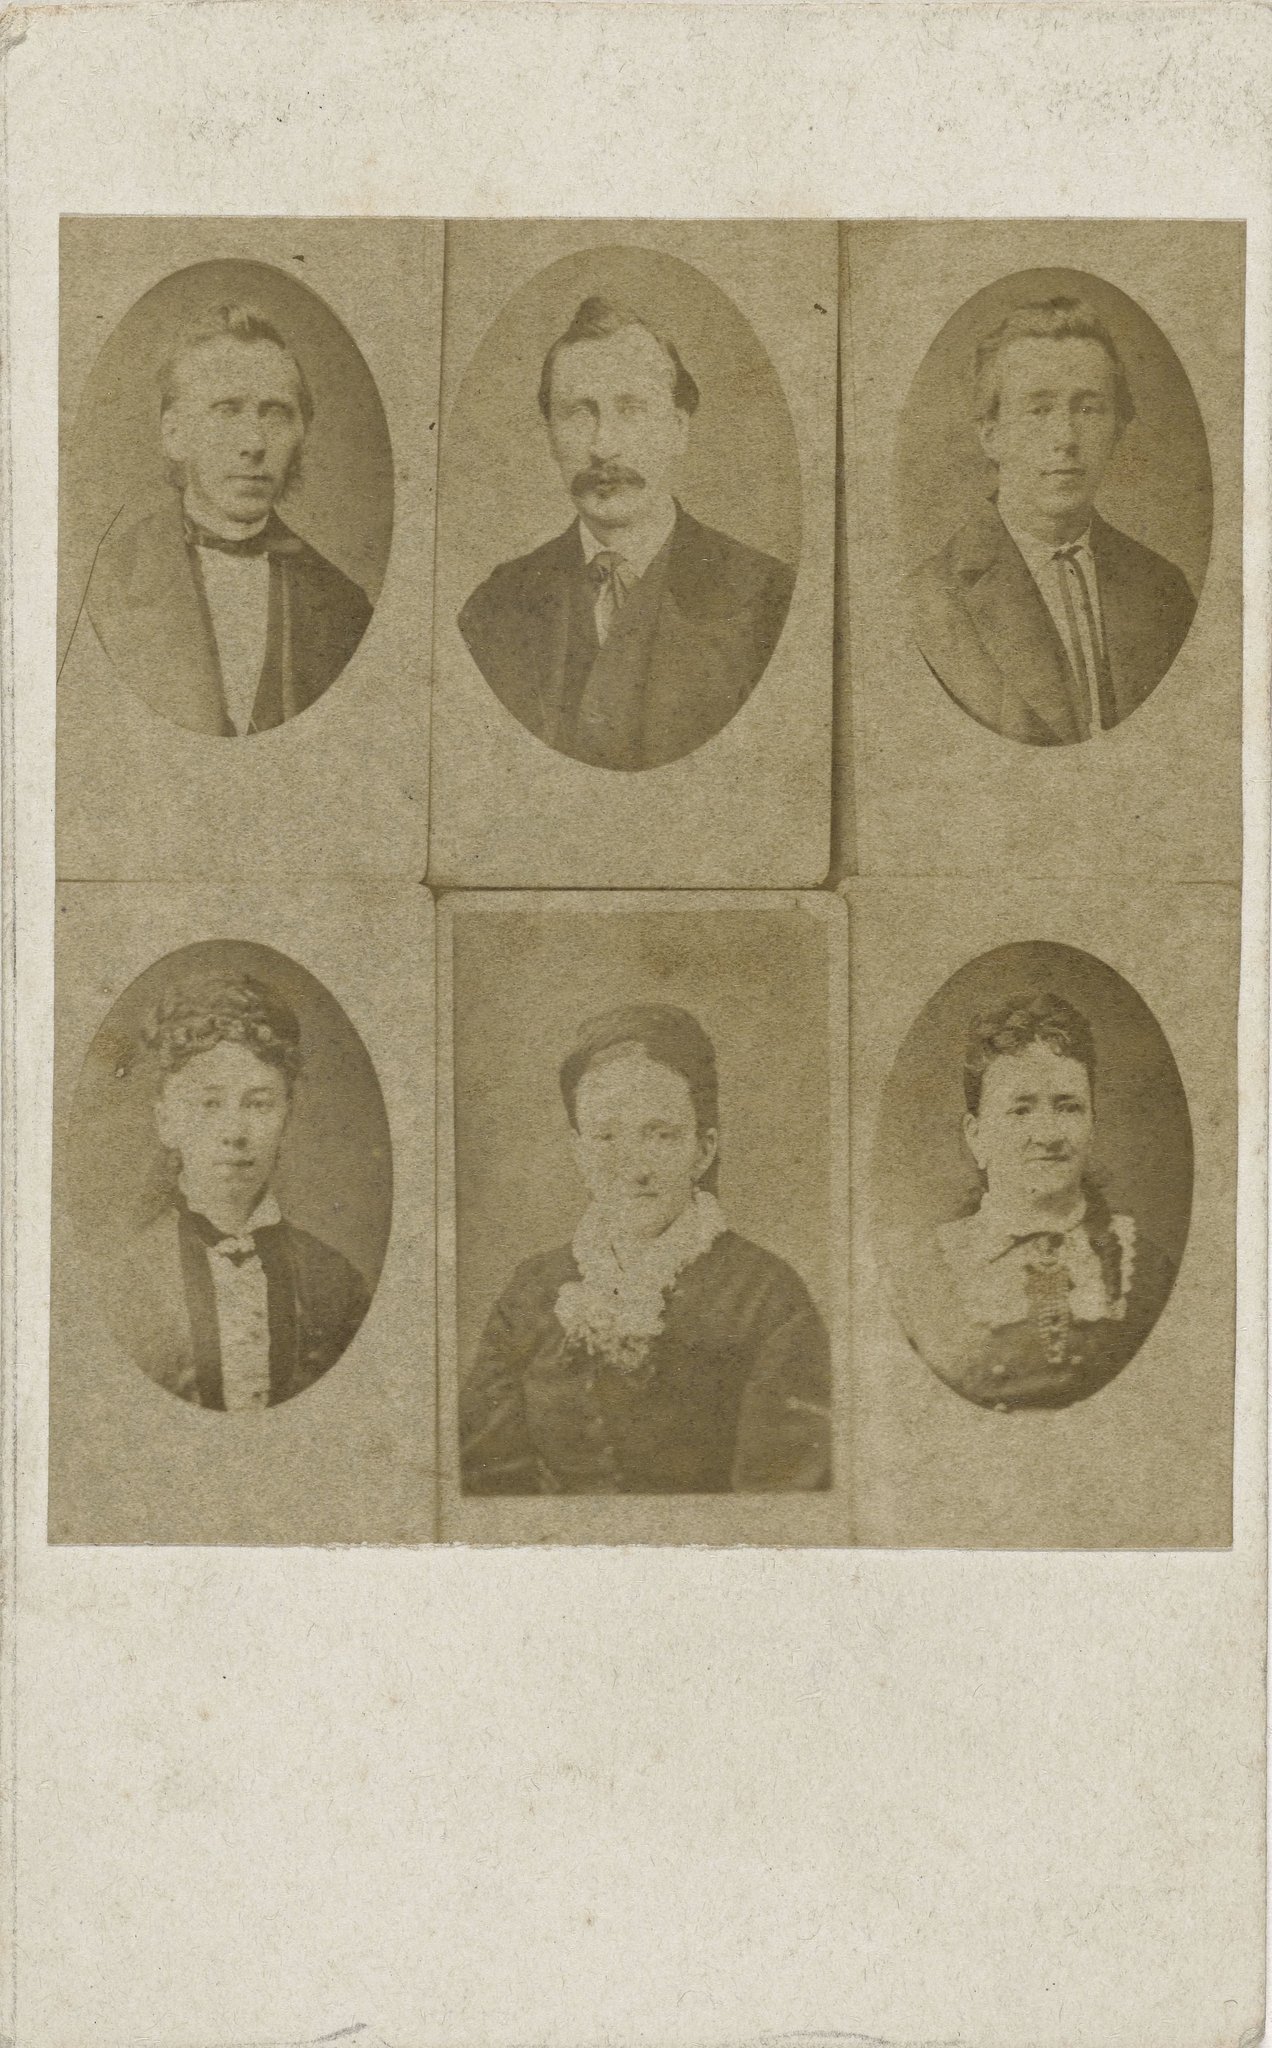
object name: photograph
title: Zes miniatuurportretten van drie onbekende mannen en drie onbekende vrouwen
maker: Anonymous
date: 1880-1900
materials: cardboard, paper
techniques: albumen print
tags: adolescent, young woman, maiden, adult man, anonymous historical person portrayed